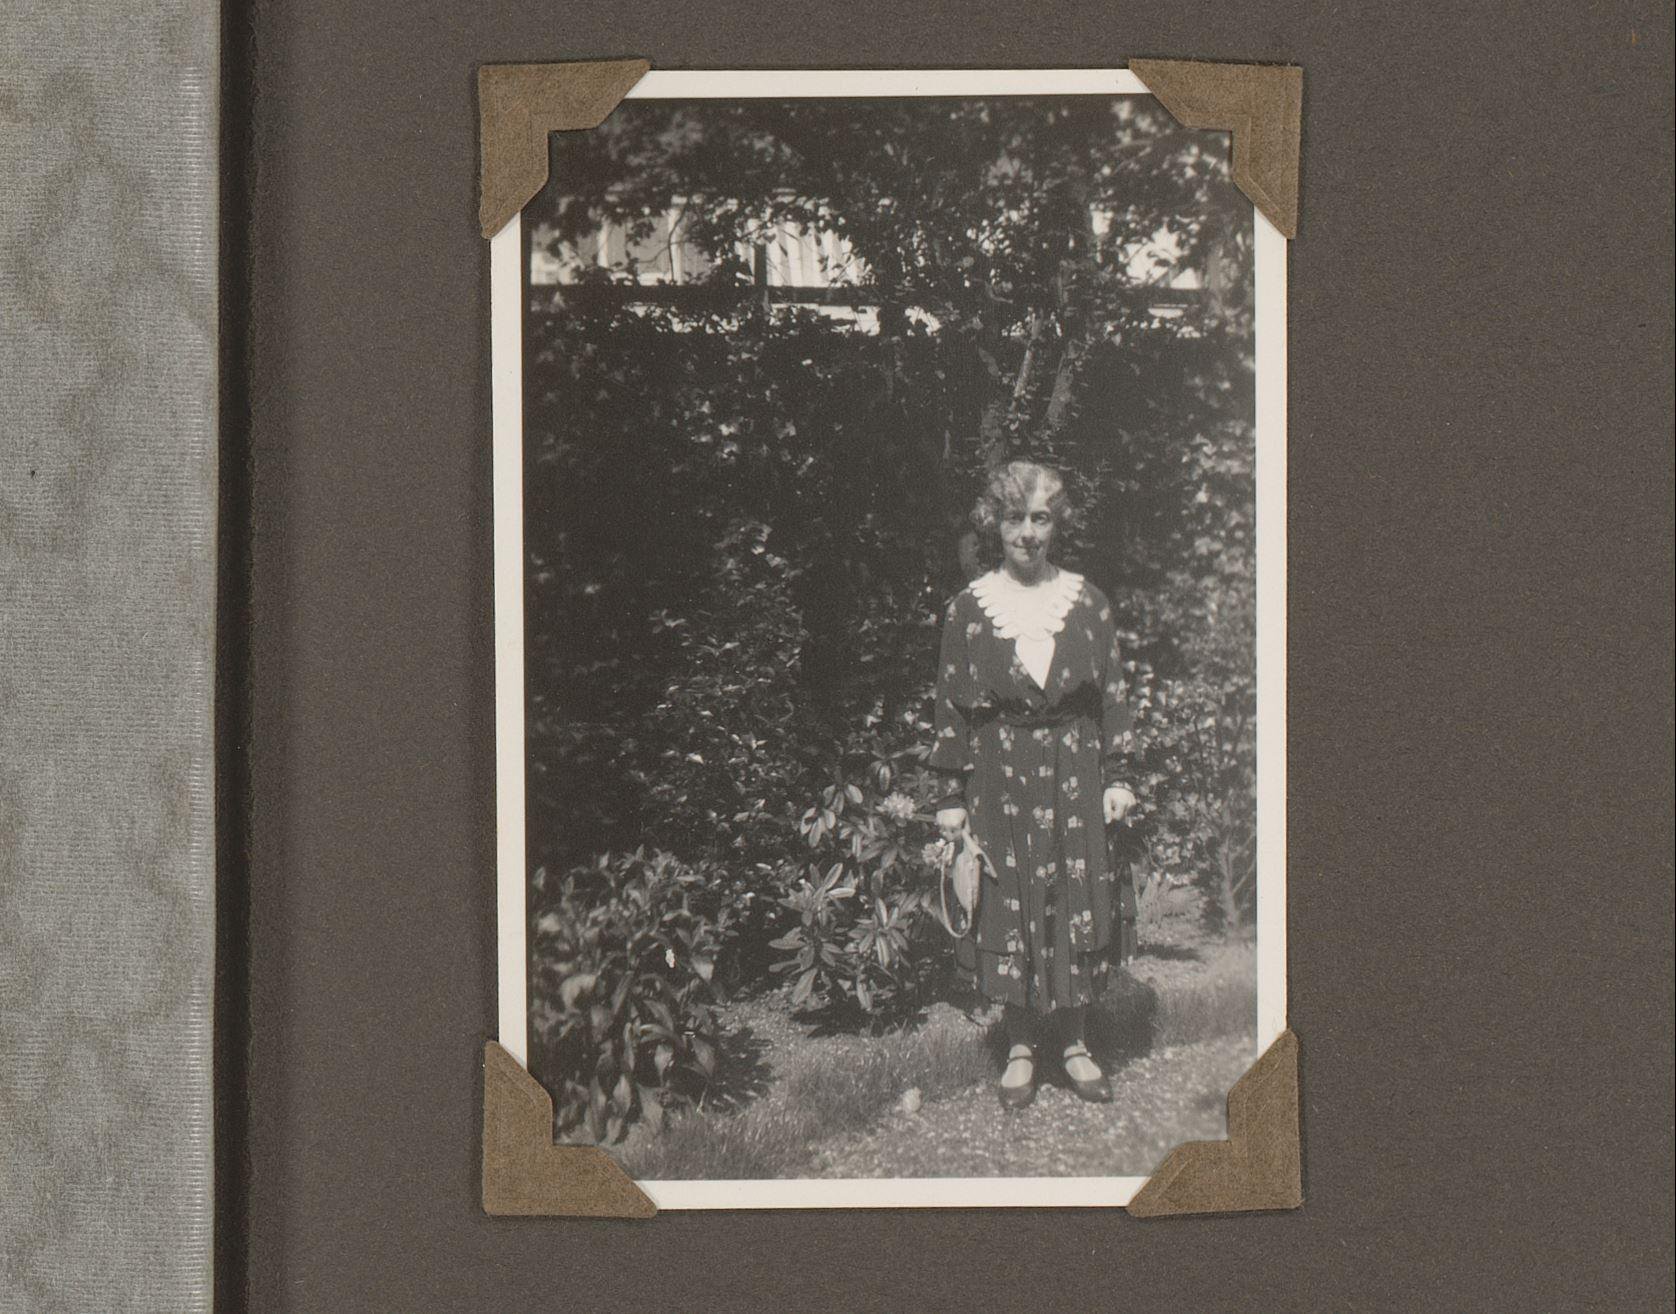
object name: album leaf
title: Portret van een vrouw met een tas in de hand, staande in een tuin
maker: Anonymous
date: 1920-1930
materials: photographic support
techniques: gelatin silver print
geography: netherlands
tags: historical persons - bb - woman, bag, garden